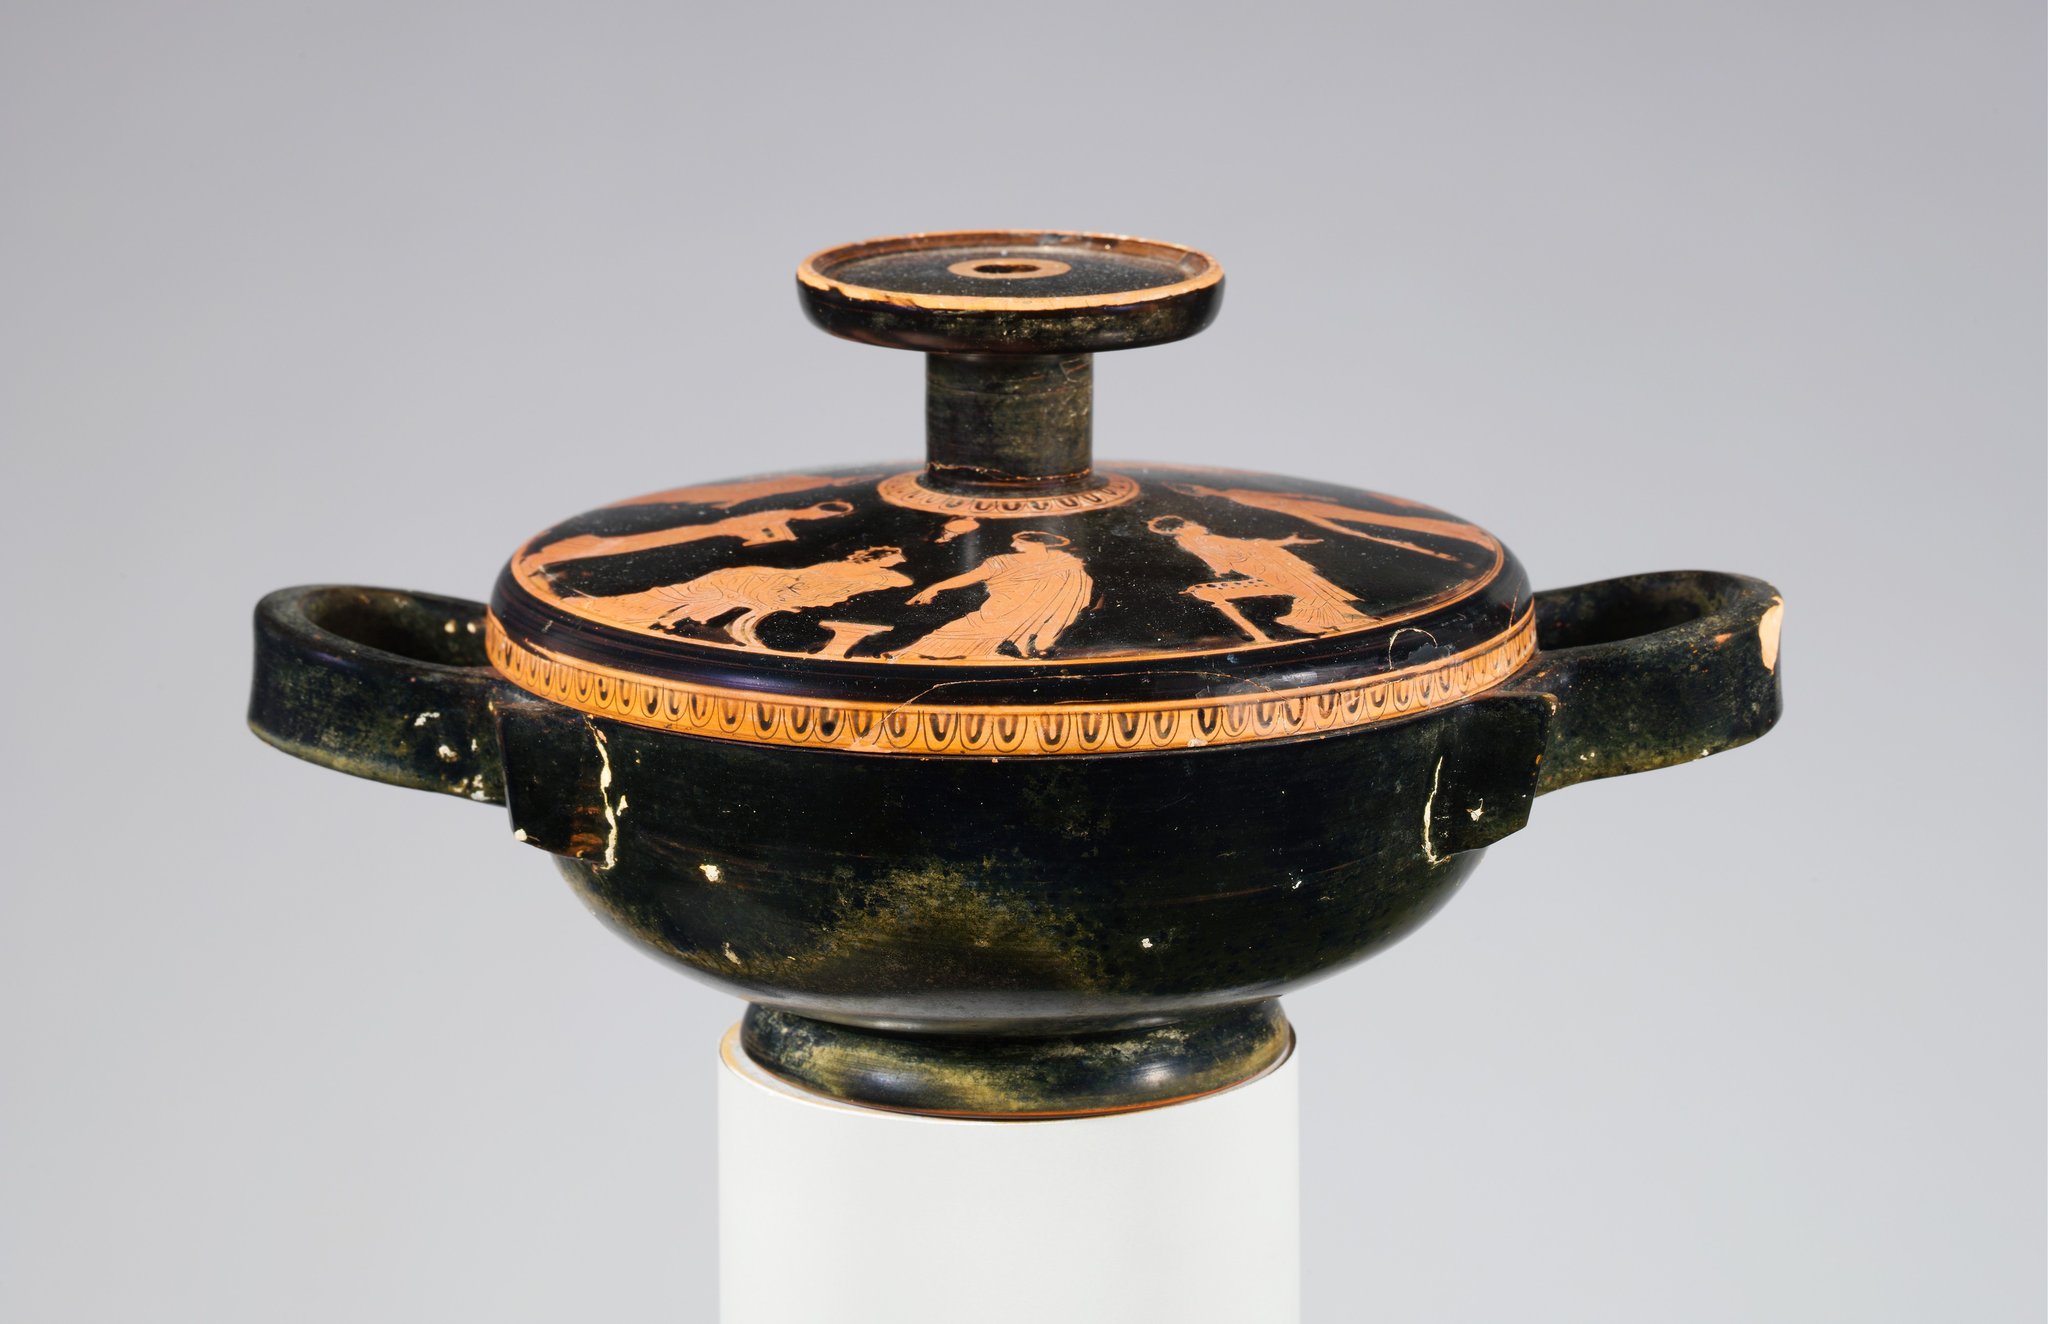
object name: lekanis with lid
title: Terracotta lekanis (covered dish)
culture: greek, attic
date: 425-401 BCE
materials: terracotta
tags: women